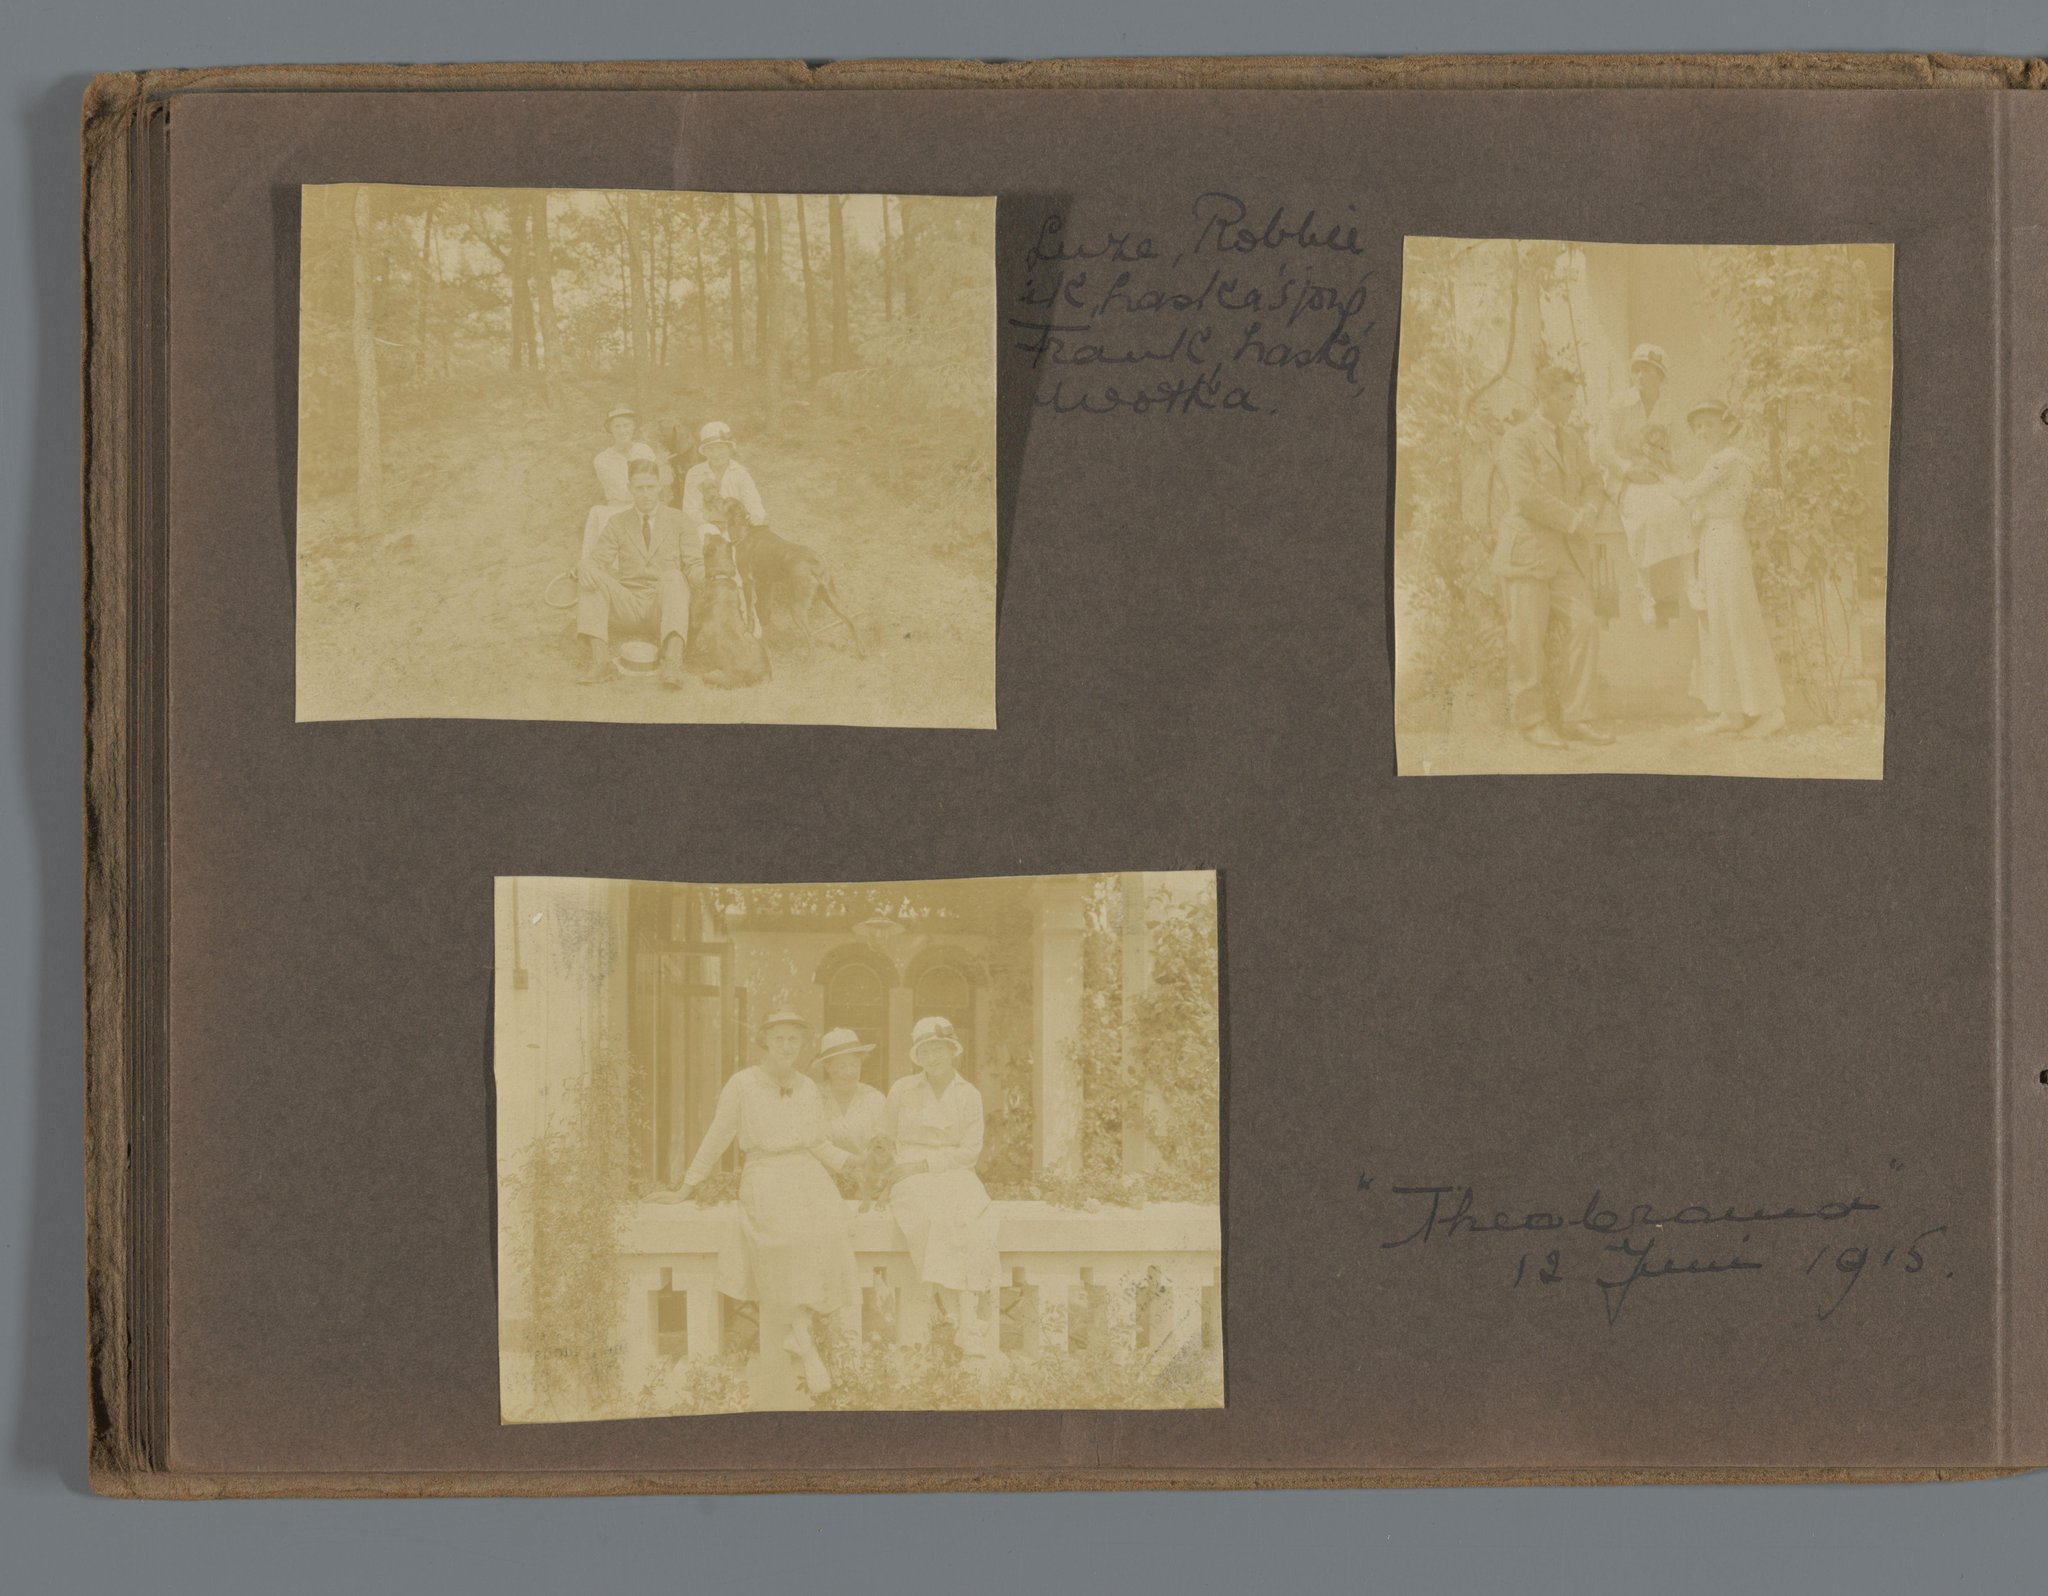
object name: photograph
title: Loentje Onnen met Luze, Robbie, Joop, Frank, Haska en Wothka bij een tennisbaan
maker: carolina frederika onnen (lien/loen)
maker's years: 1896-1983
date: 1915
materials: paper, cardboard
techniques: gelatin silver print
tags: amsterdam, carolina frederika onnen (lien/loen), tennis, lawn-tennis, friends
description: Deze foto's zijn onderdeel van een album.